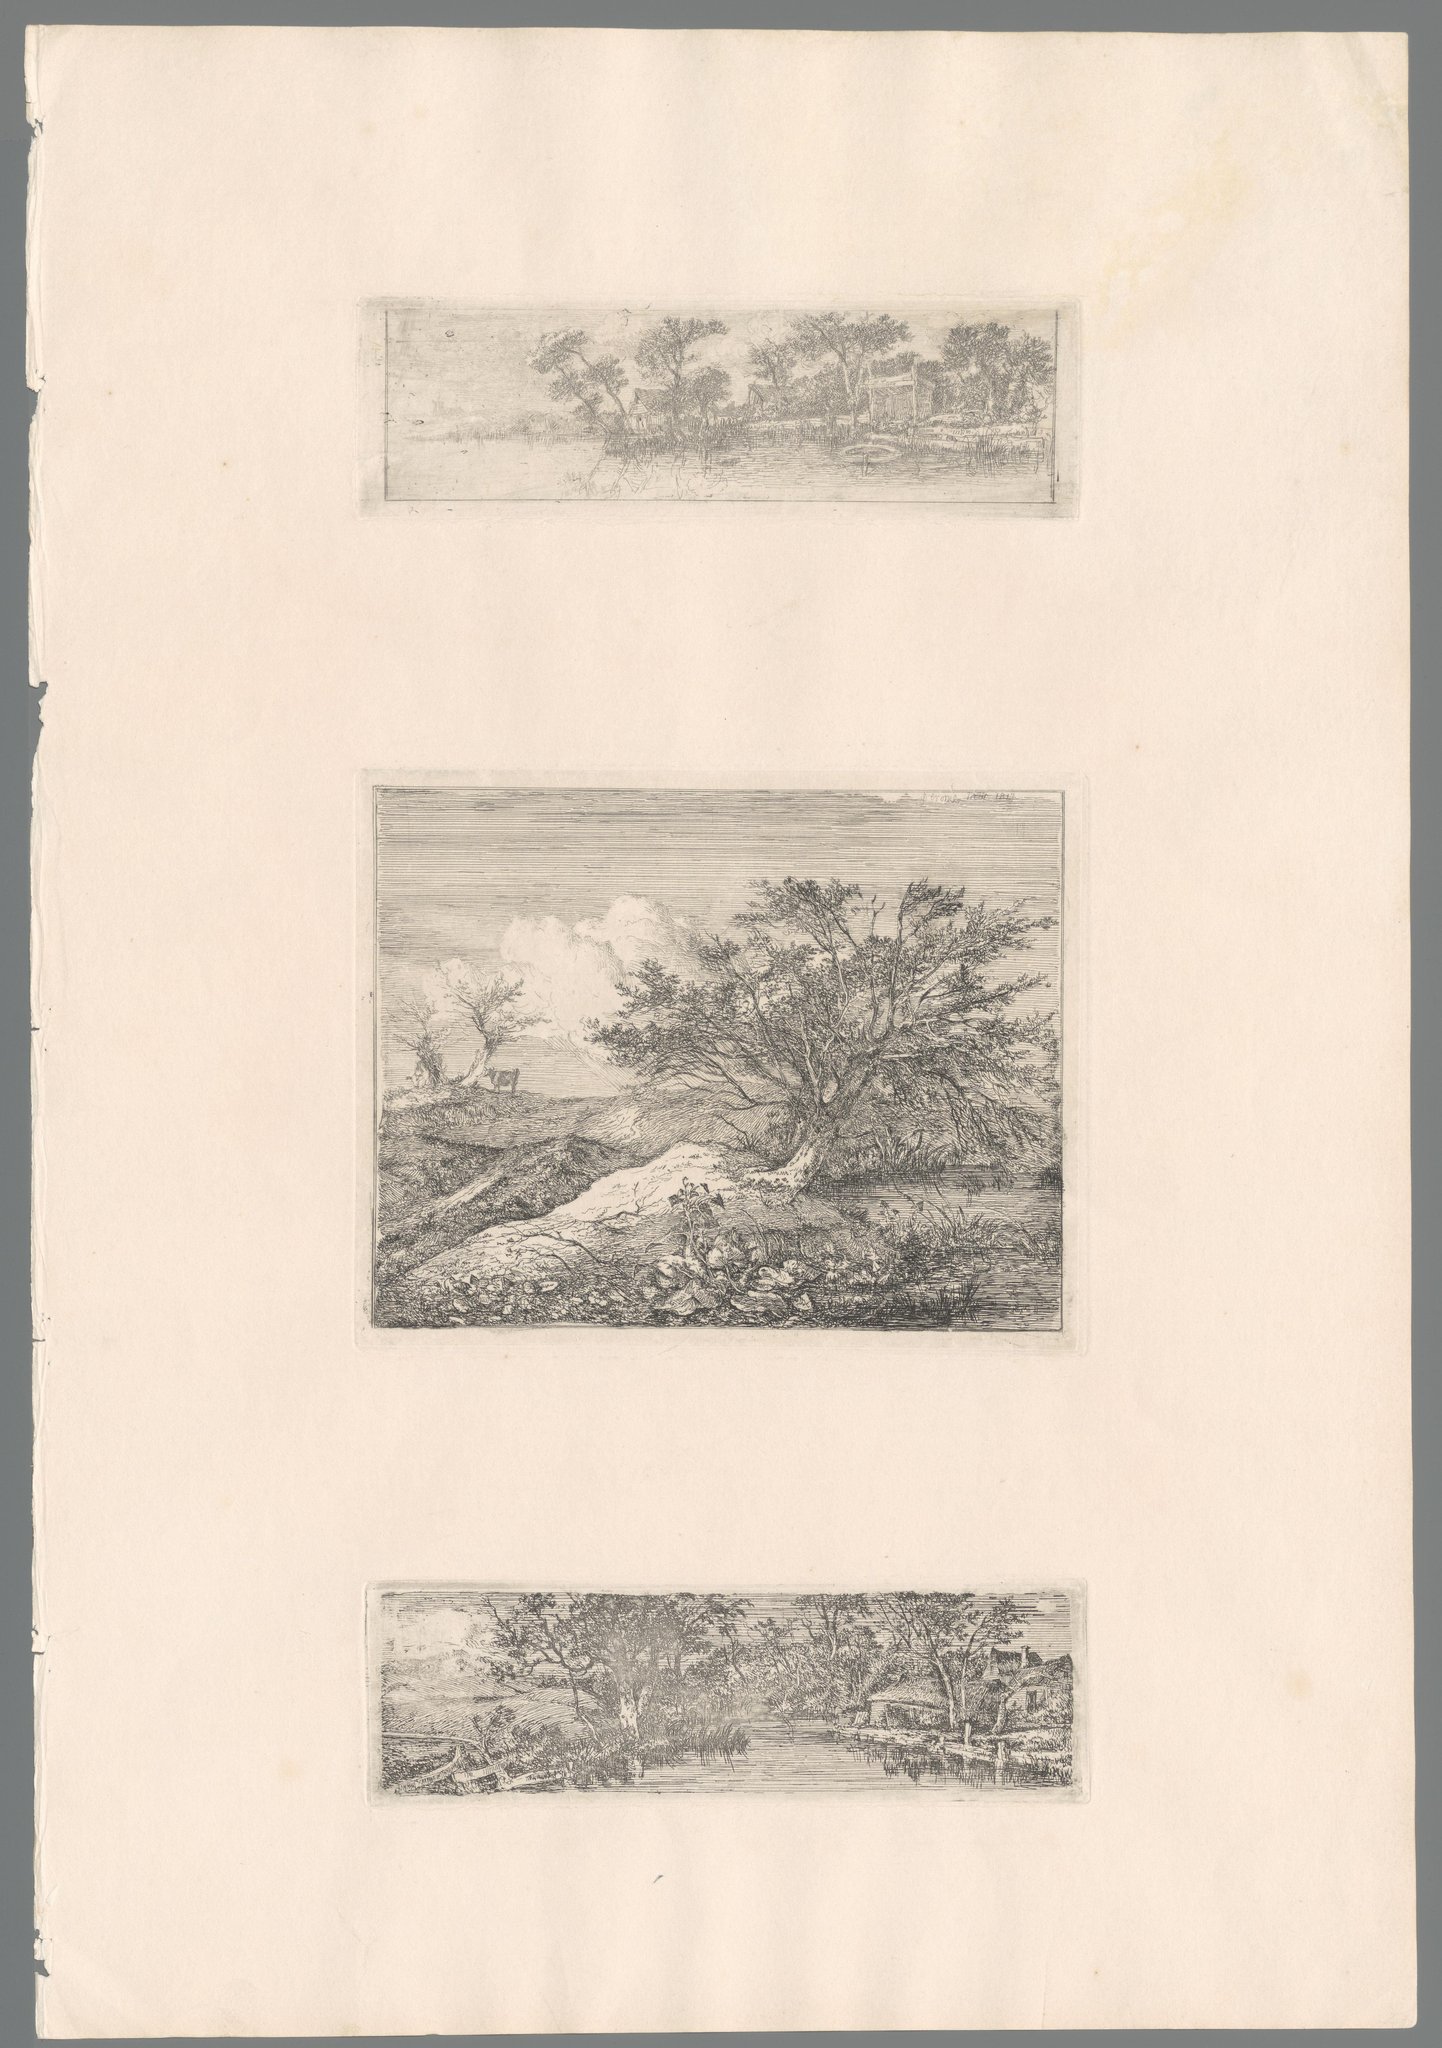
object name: print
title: Norfolk Picturesque Scenery (...) thirty-one etchings, by the late John Crome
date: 1834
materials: paper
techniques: etching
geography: norwich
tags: lake, windmill in landscape, cottage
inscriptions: collector's mark: Lugt 2760, collector's mark: Lugt 2228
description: Prent staat samen met RP-P-1973-186 en RP-P-1973-187 op een onversneden blad.